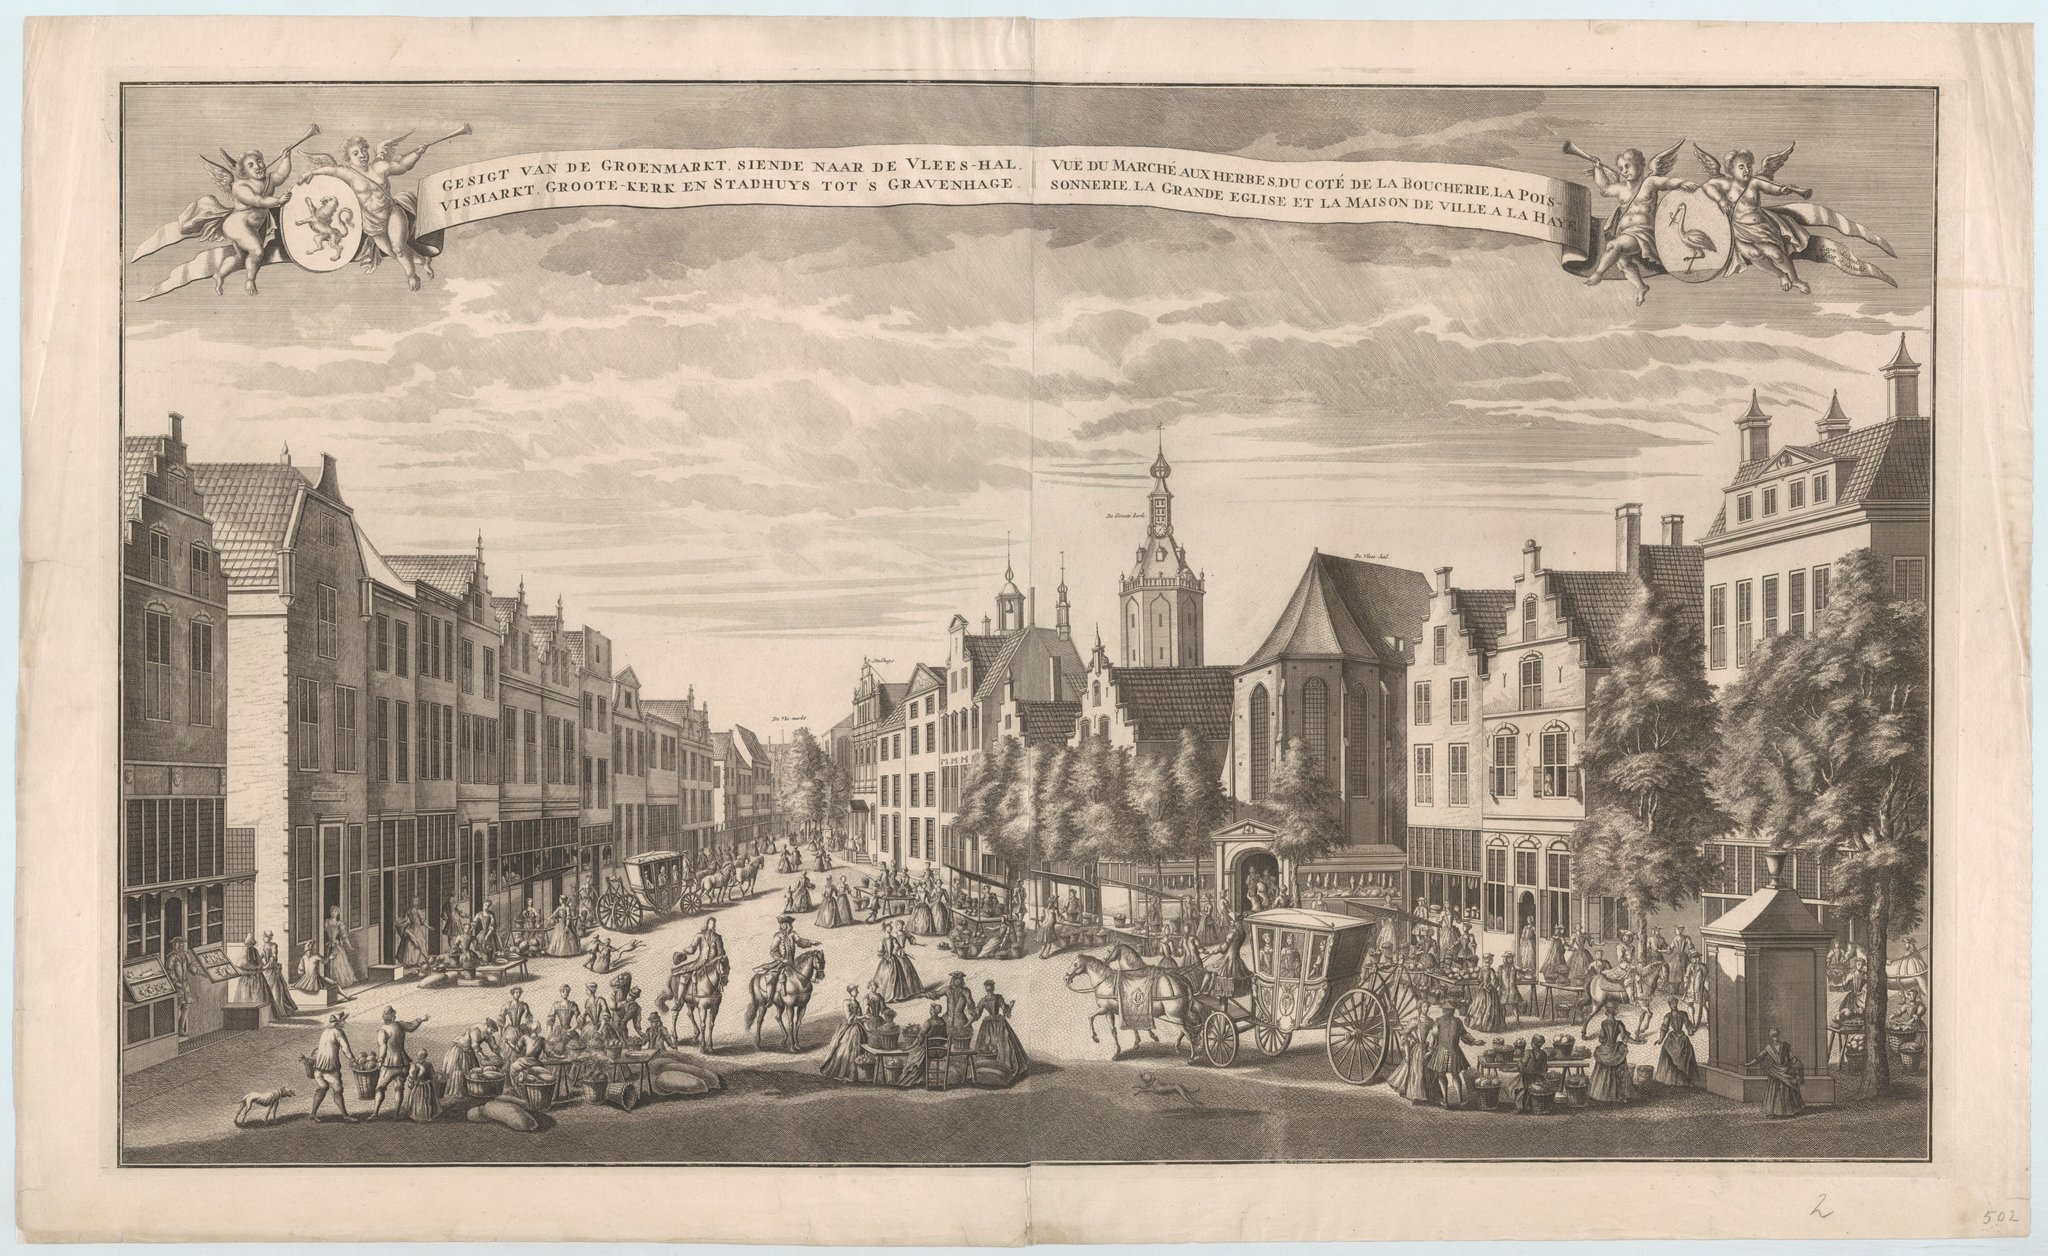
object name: print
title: Gesigt van de groenmarkt siende naar de vlees-hal, vismarkt, groote-kerk en stadhuys tot 's Gravenhage / Vue du marche aux herbes, du coté de la boucherie la pois-sonnerie la grande eglise et la maison de ville a la Haye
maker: leonard schenk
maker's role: print maker, publisher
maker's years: 1696-1767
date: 1740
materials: paper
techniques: engraving, etching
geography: amsterdam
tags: vegetables, market, fruits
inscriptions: stamp, collector's mark: Lugt 1641, stamp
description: Gezicht op de Groenmarkt. Rond de markt bevinden zich de Vleeshal, het stadhuis, de Grote Kerk en de Vismarkt. Onderwerpsrubrieken binnen de Atlas Zeden en Gewoonten: Marktwezen, 's-Gravenhage.